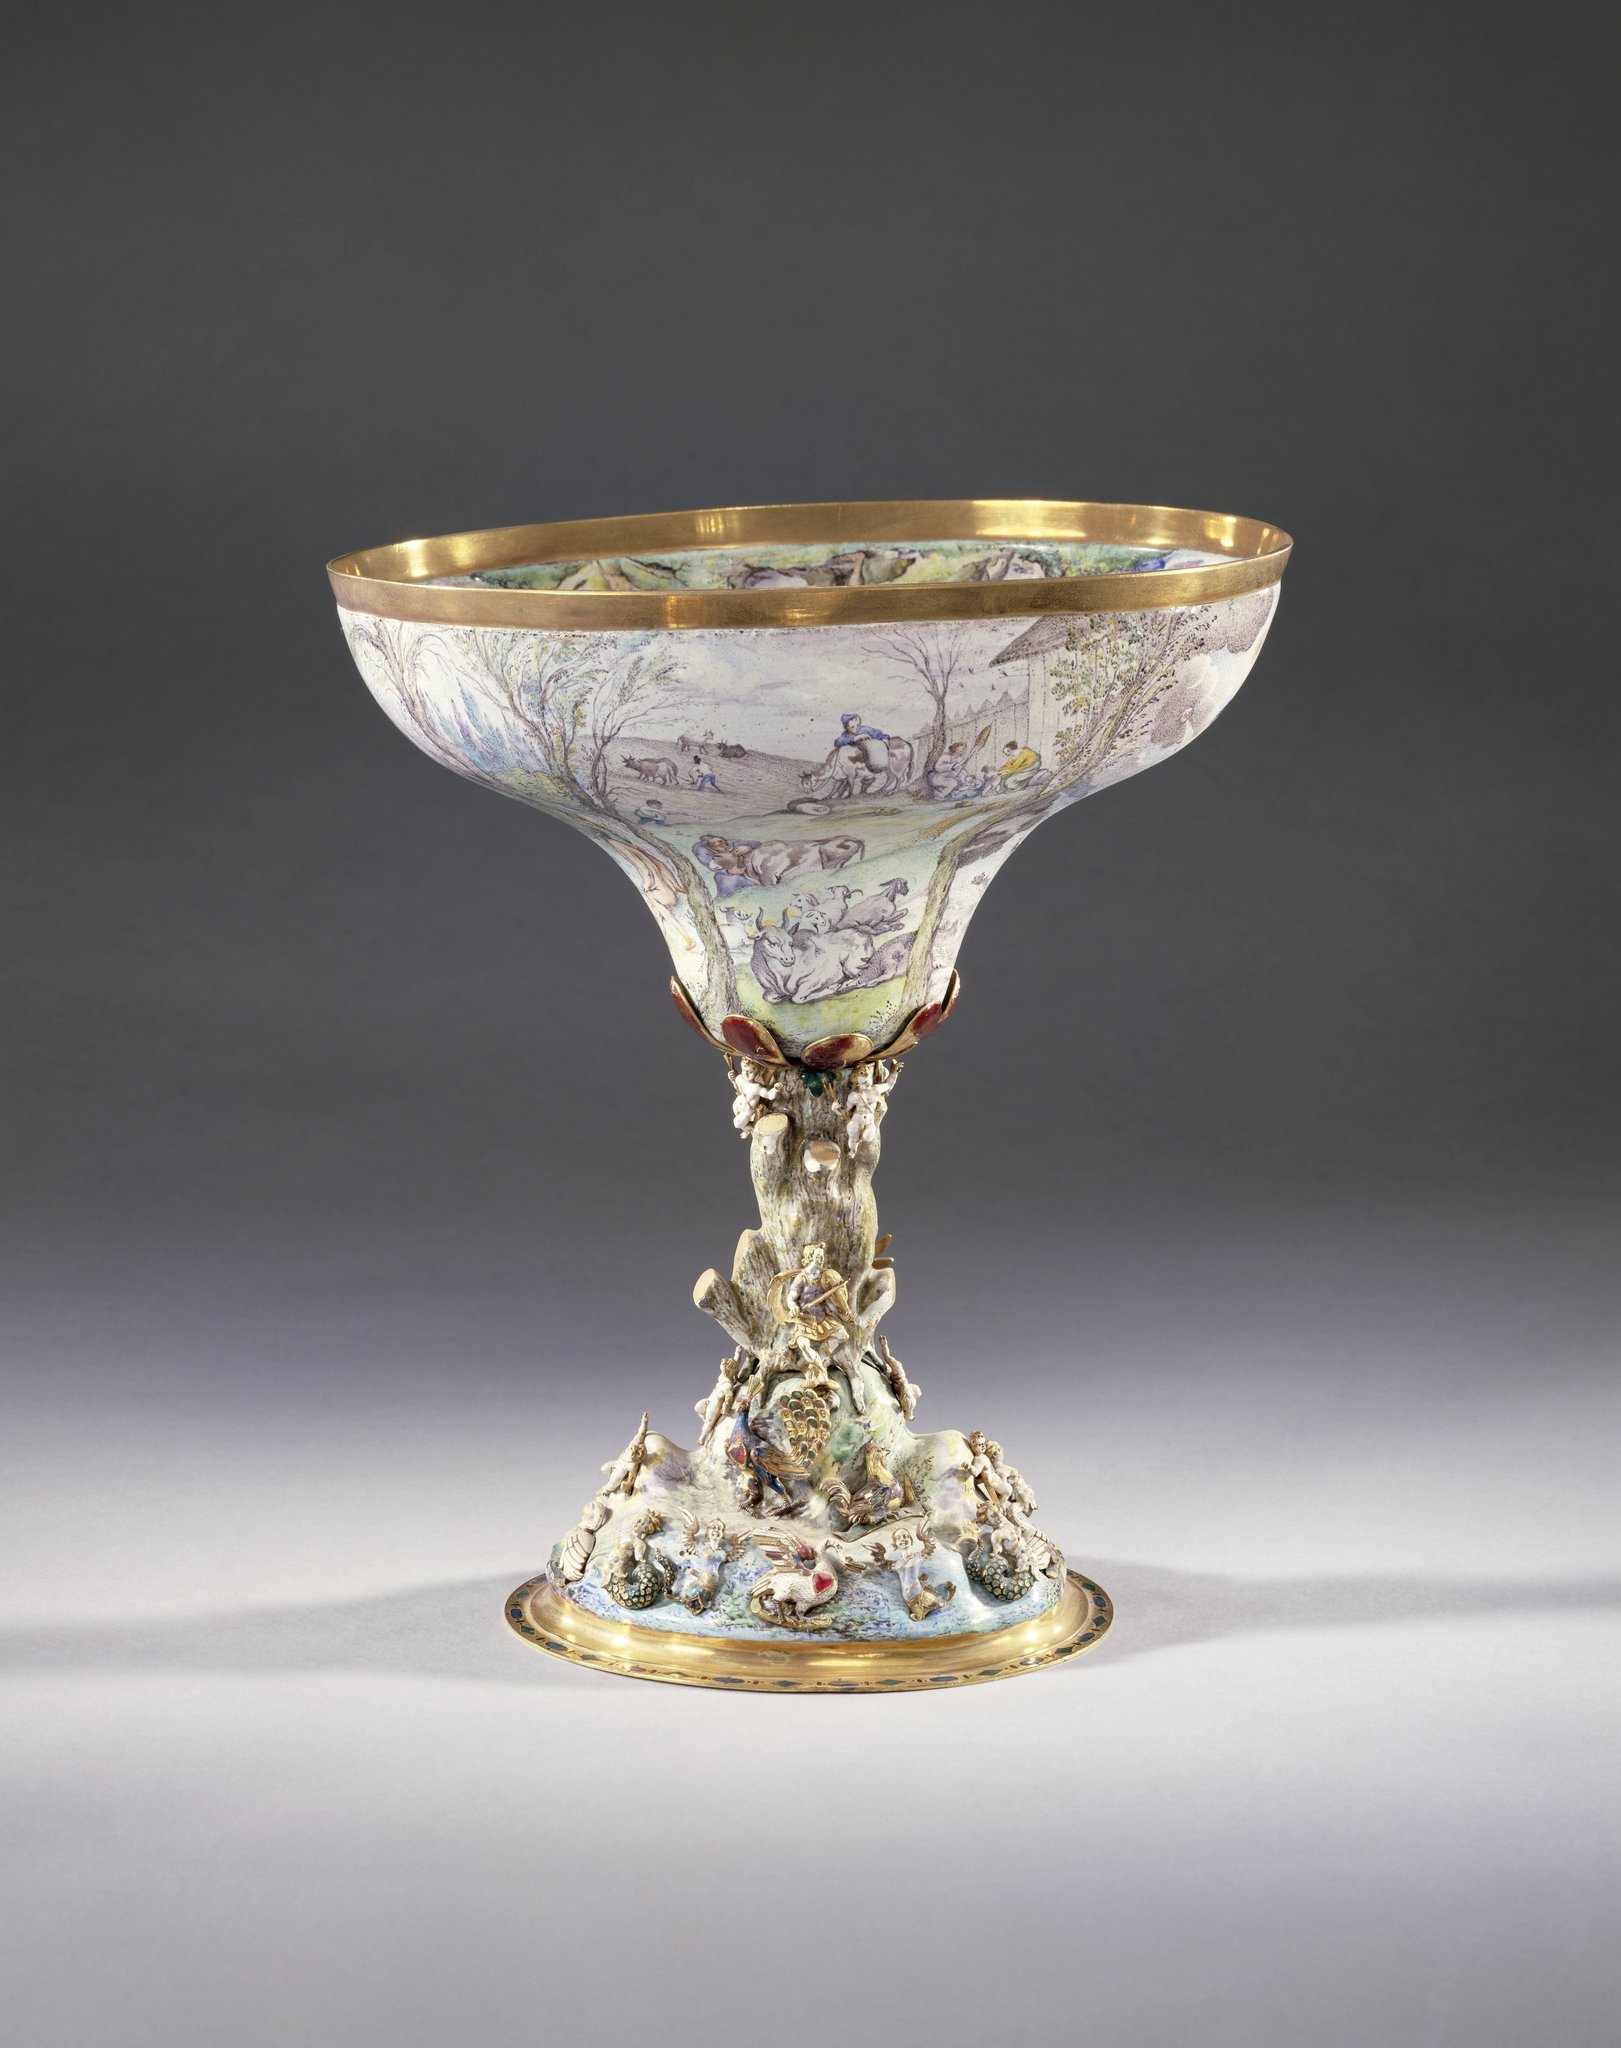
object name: goblet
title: Cup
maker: Anonymous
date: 1660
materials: gold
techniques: enamel, émail en ronde bosse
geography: vienna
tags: the four world epochs (golden, silver, bronze, iron age); 'età dell'oro, argento, bronzo, et ferro' (ripa), orpheus playing the lyre: trees and rocks move, beasts and birds are enchanted (+ variant)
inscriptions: signature: ‘G. LOT F.’, signature: ‘IGB’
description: The foot and stem of this cup resemble an island with a pollarded tree. Leaning against its trunk is Orpheus, the mythical bard who could charm animals with his lyre. His audience consists of all kinds of birds and a few imaginary creatures, including winged mermaids. The bowl is ornamented with scenes from Ovid’s Metamorphoses.